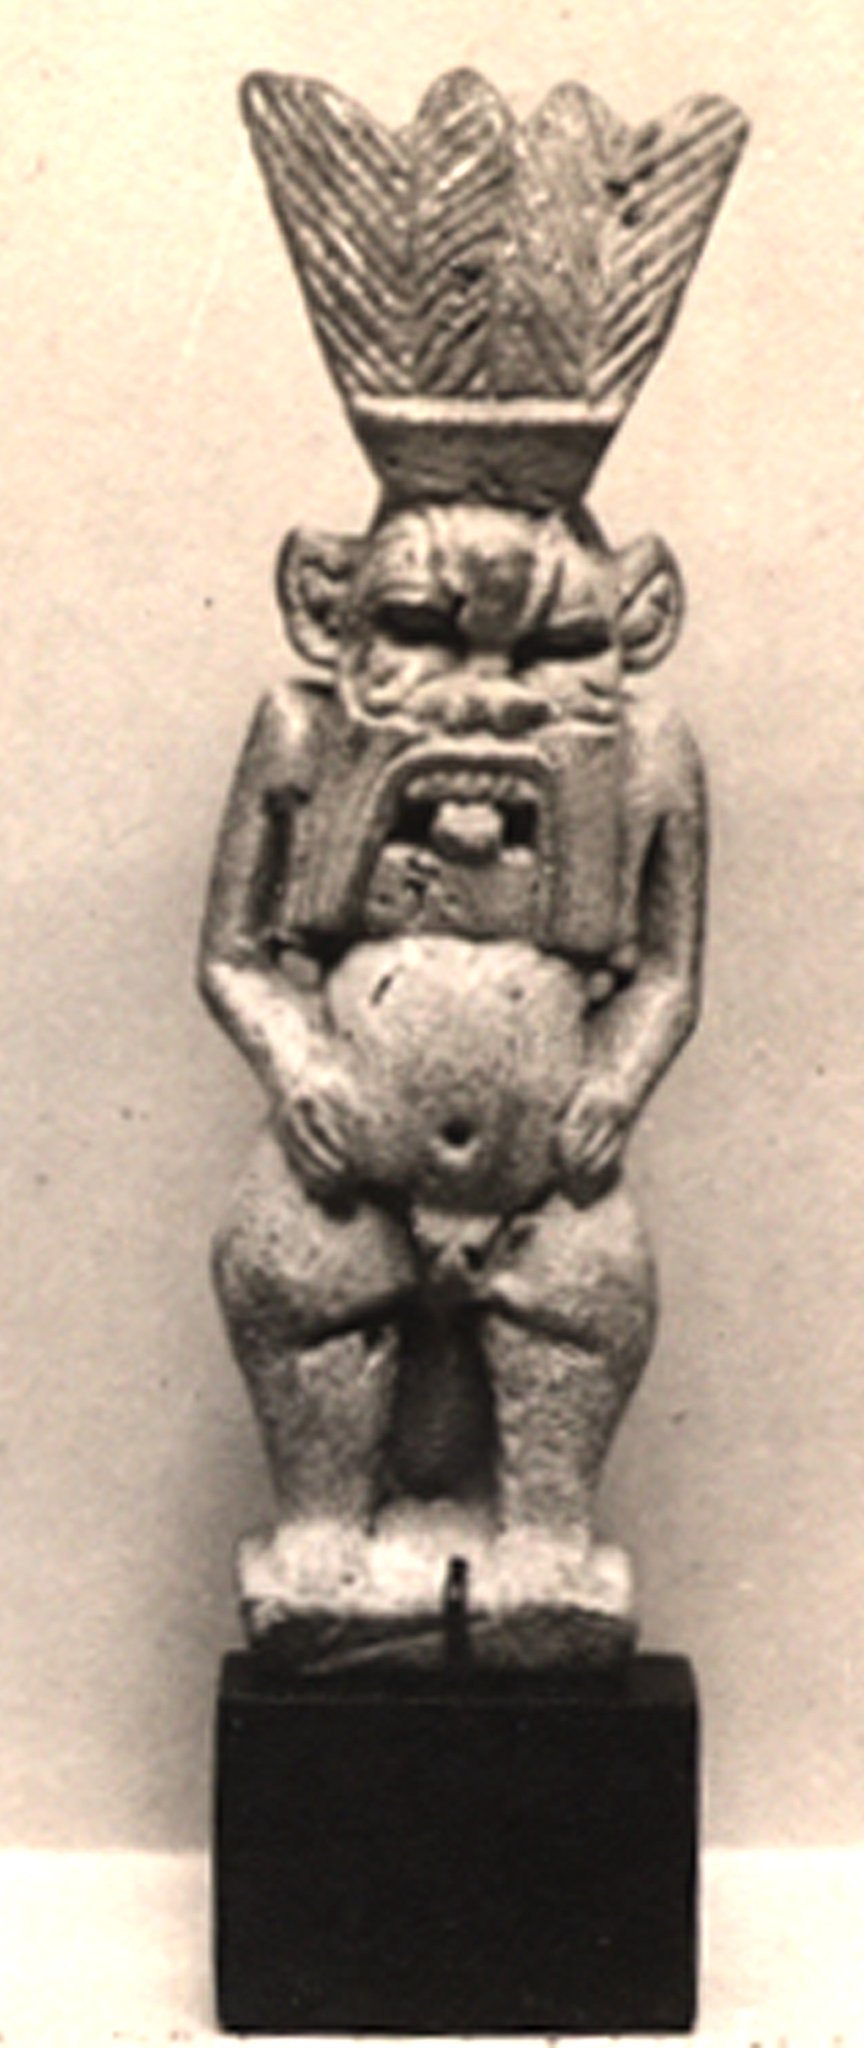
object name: amulet, be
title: Amulet of Bes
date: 1070-664 BCE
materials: faience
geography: egypt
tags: bes